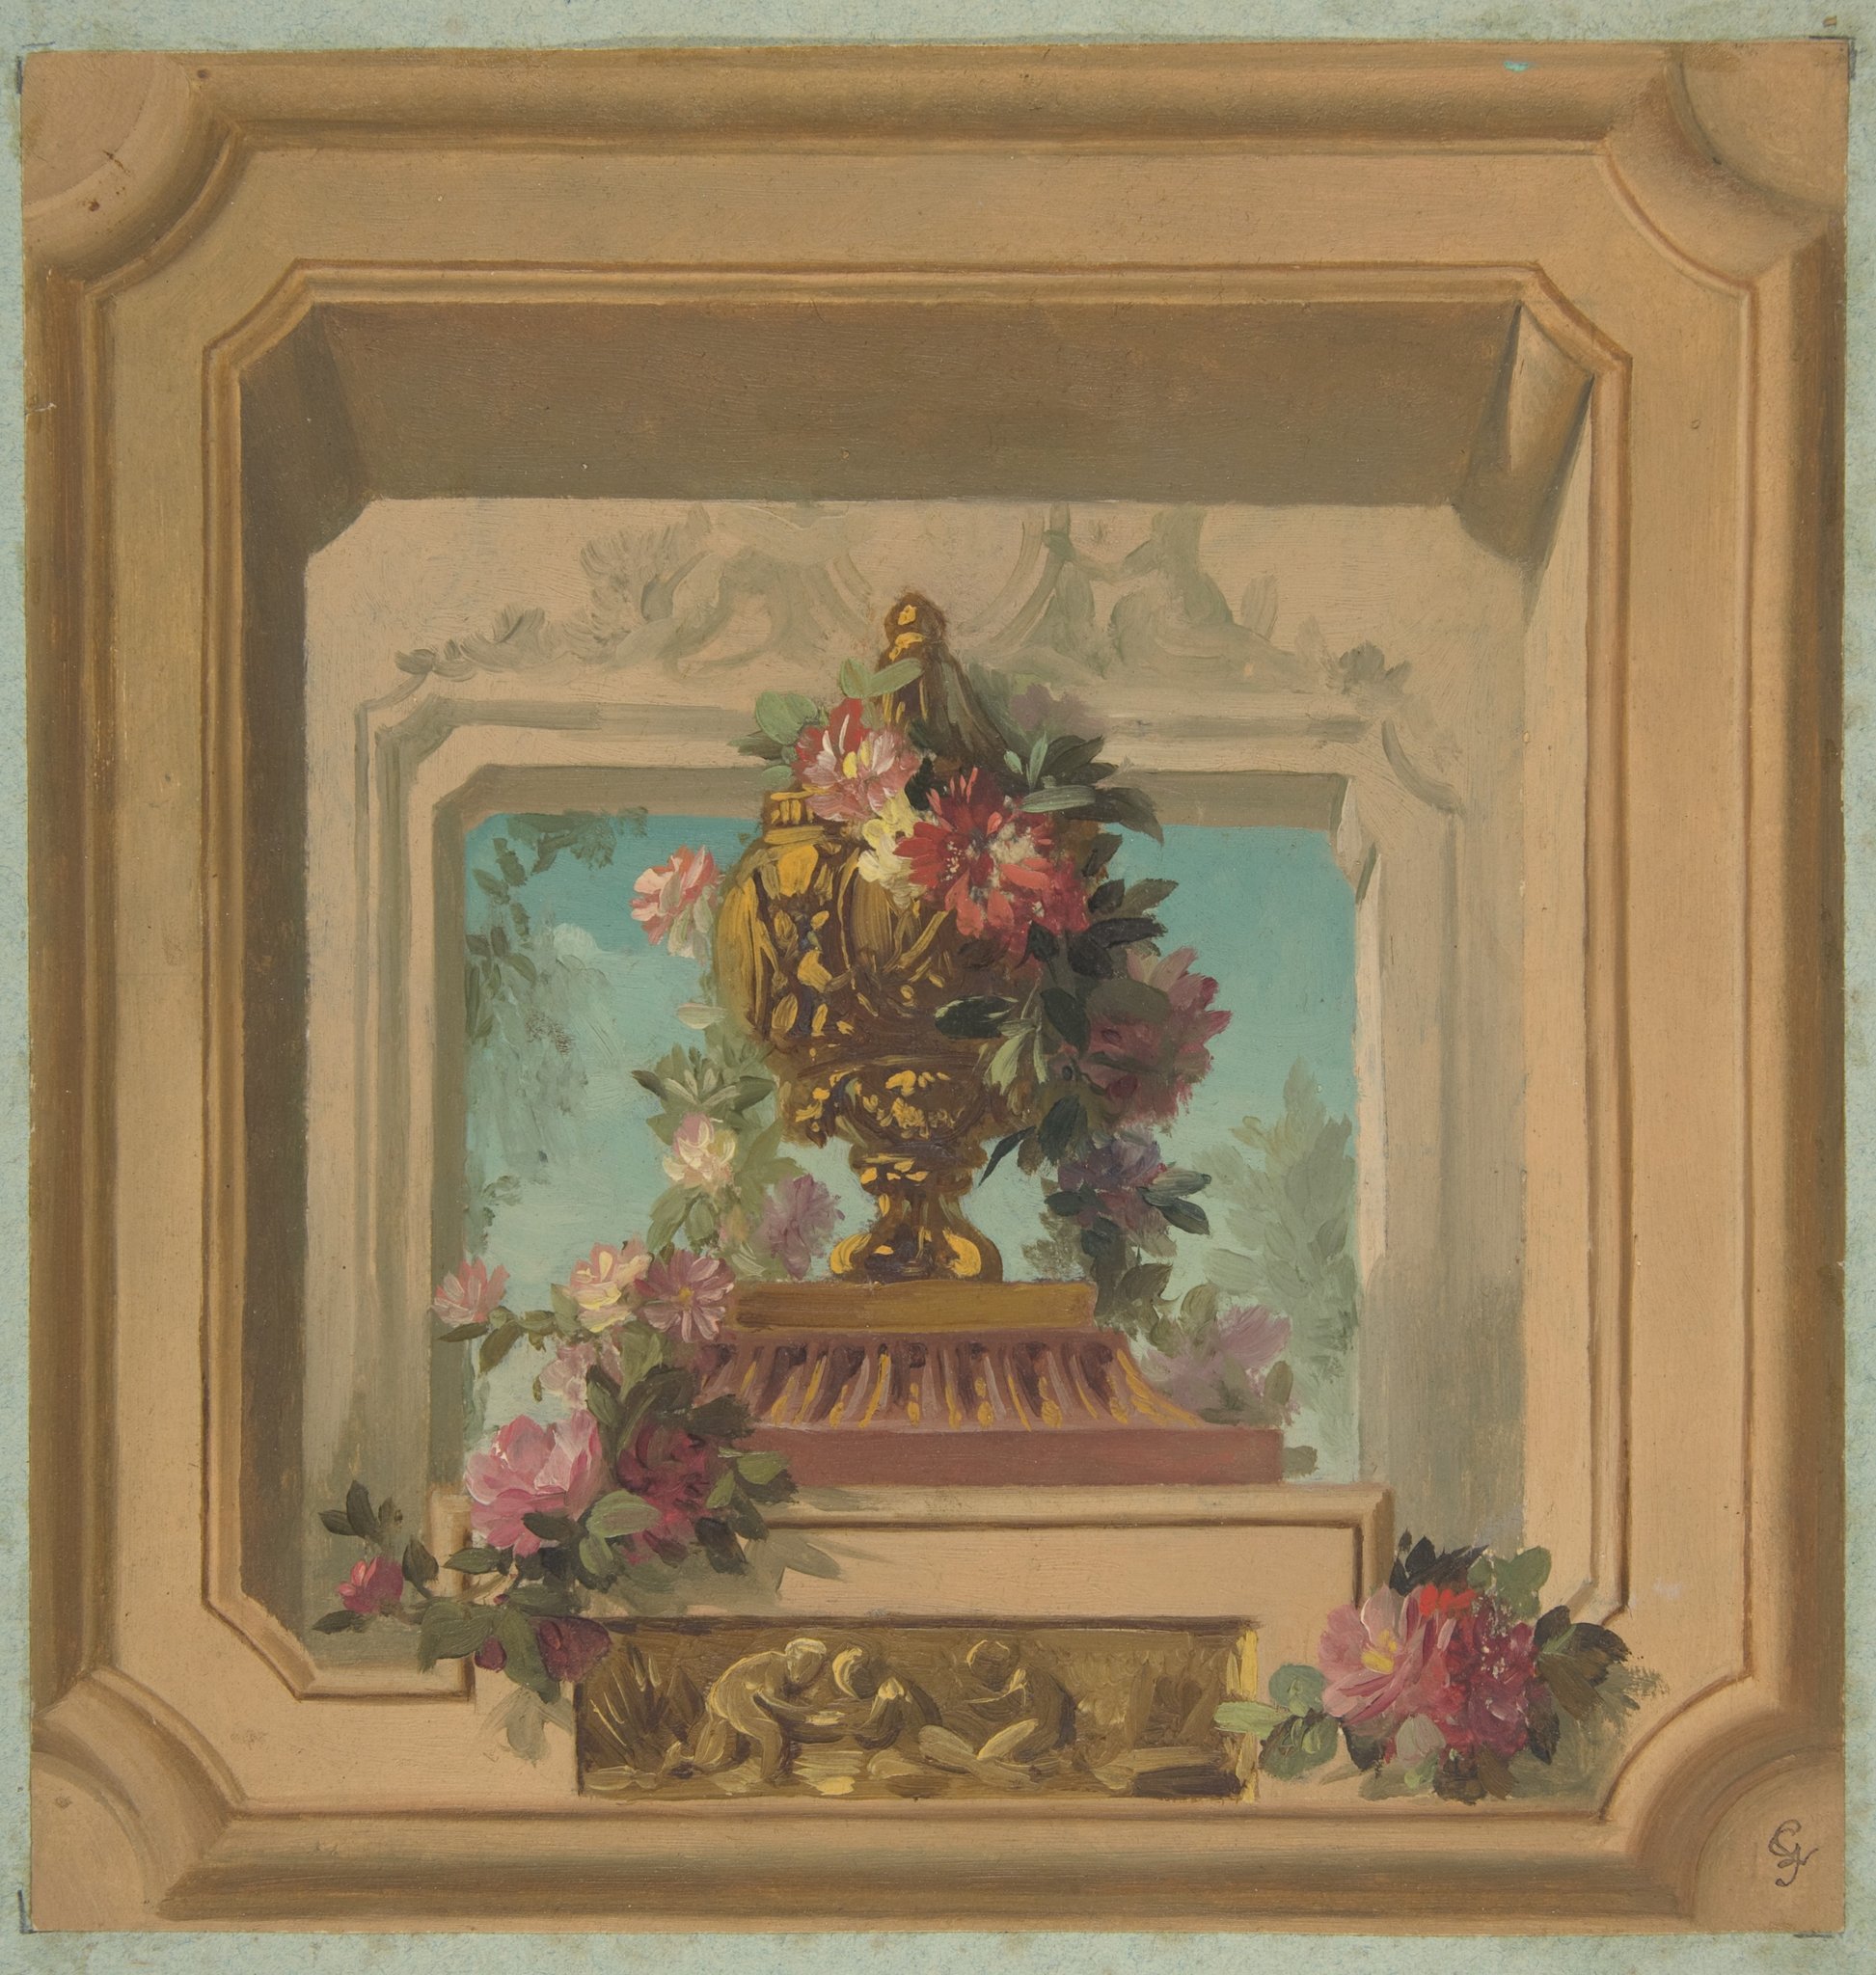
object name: drawing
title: Trompe l'oeil design for a ceiling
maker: jules-edmond-charles lachaise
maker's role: artist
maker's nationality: french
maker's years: 1897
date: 1851-1900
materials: oil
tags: human figures,flowers,leaves,vases